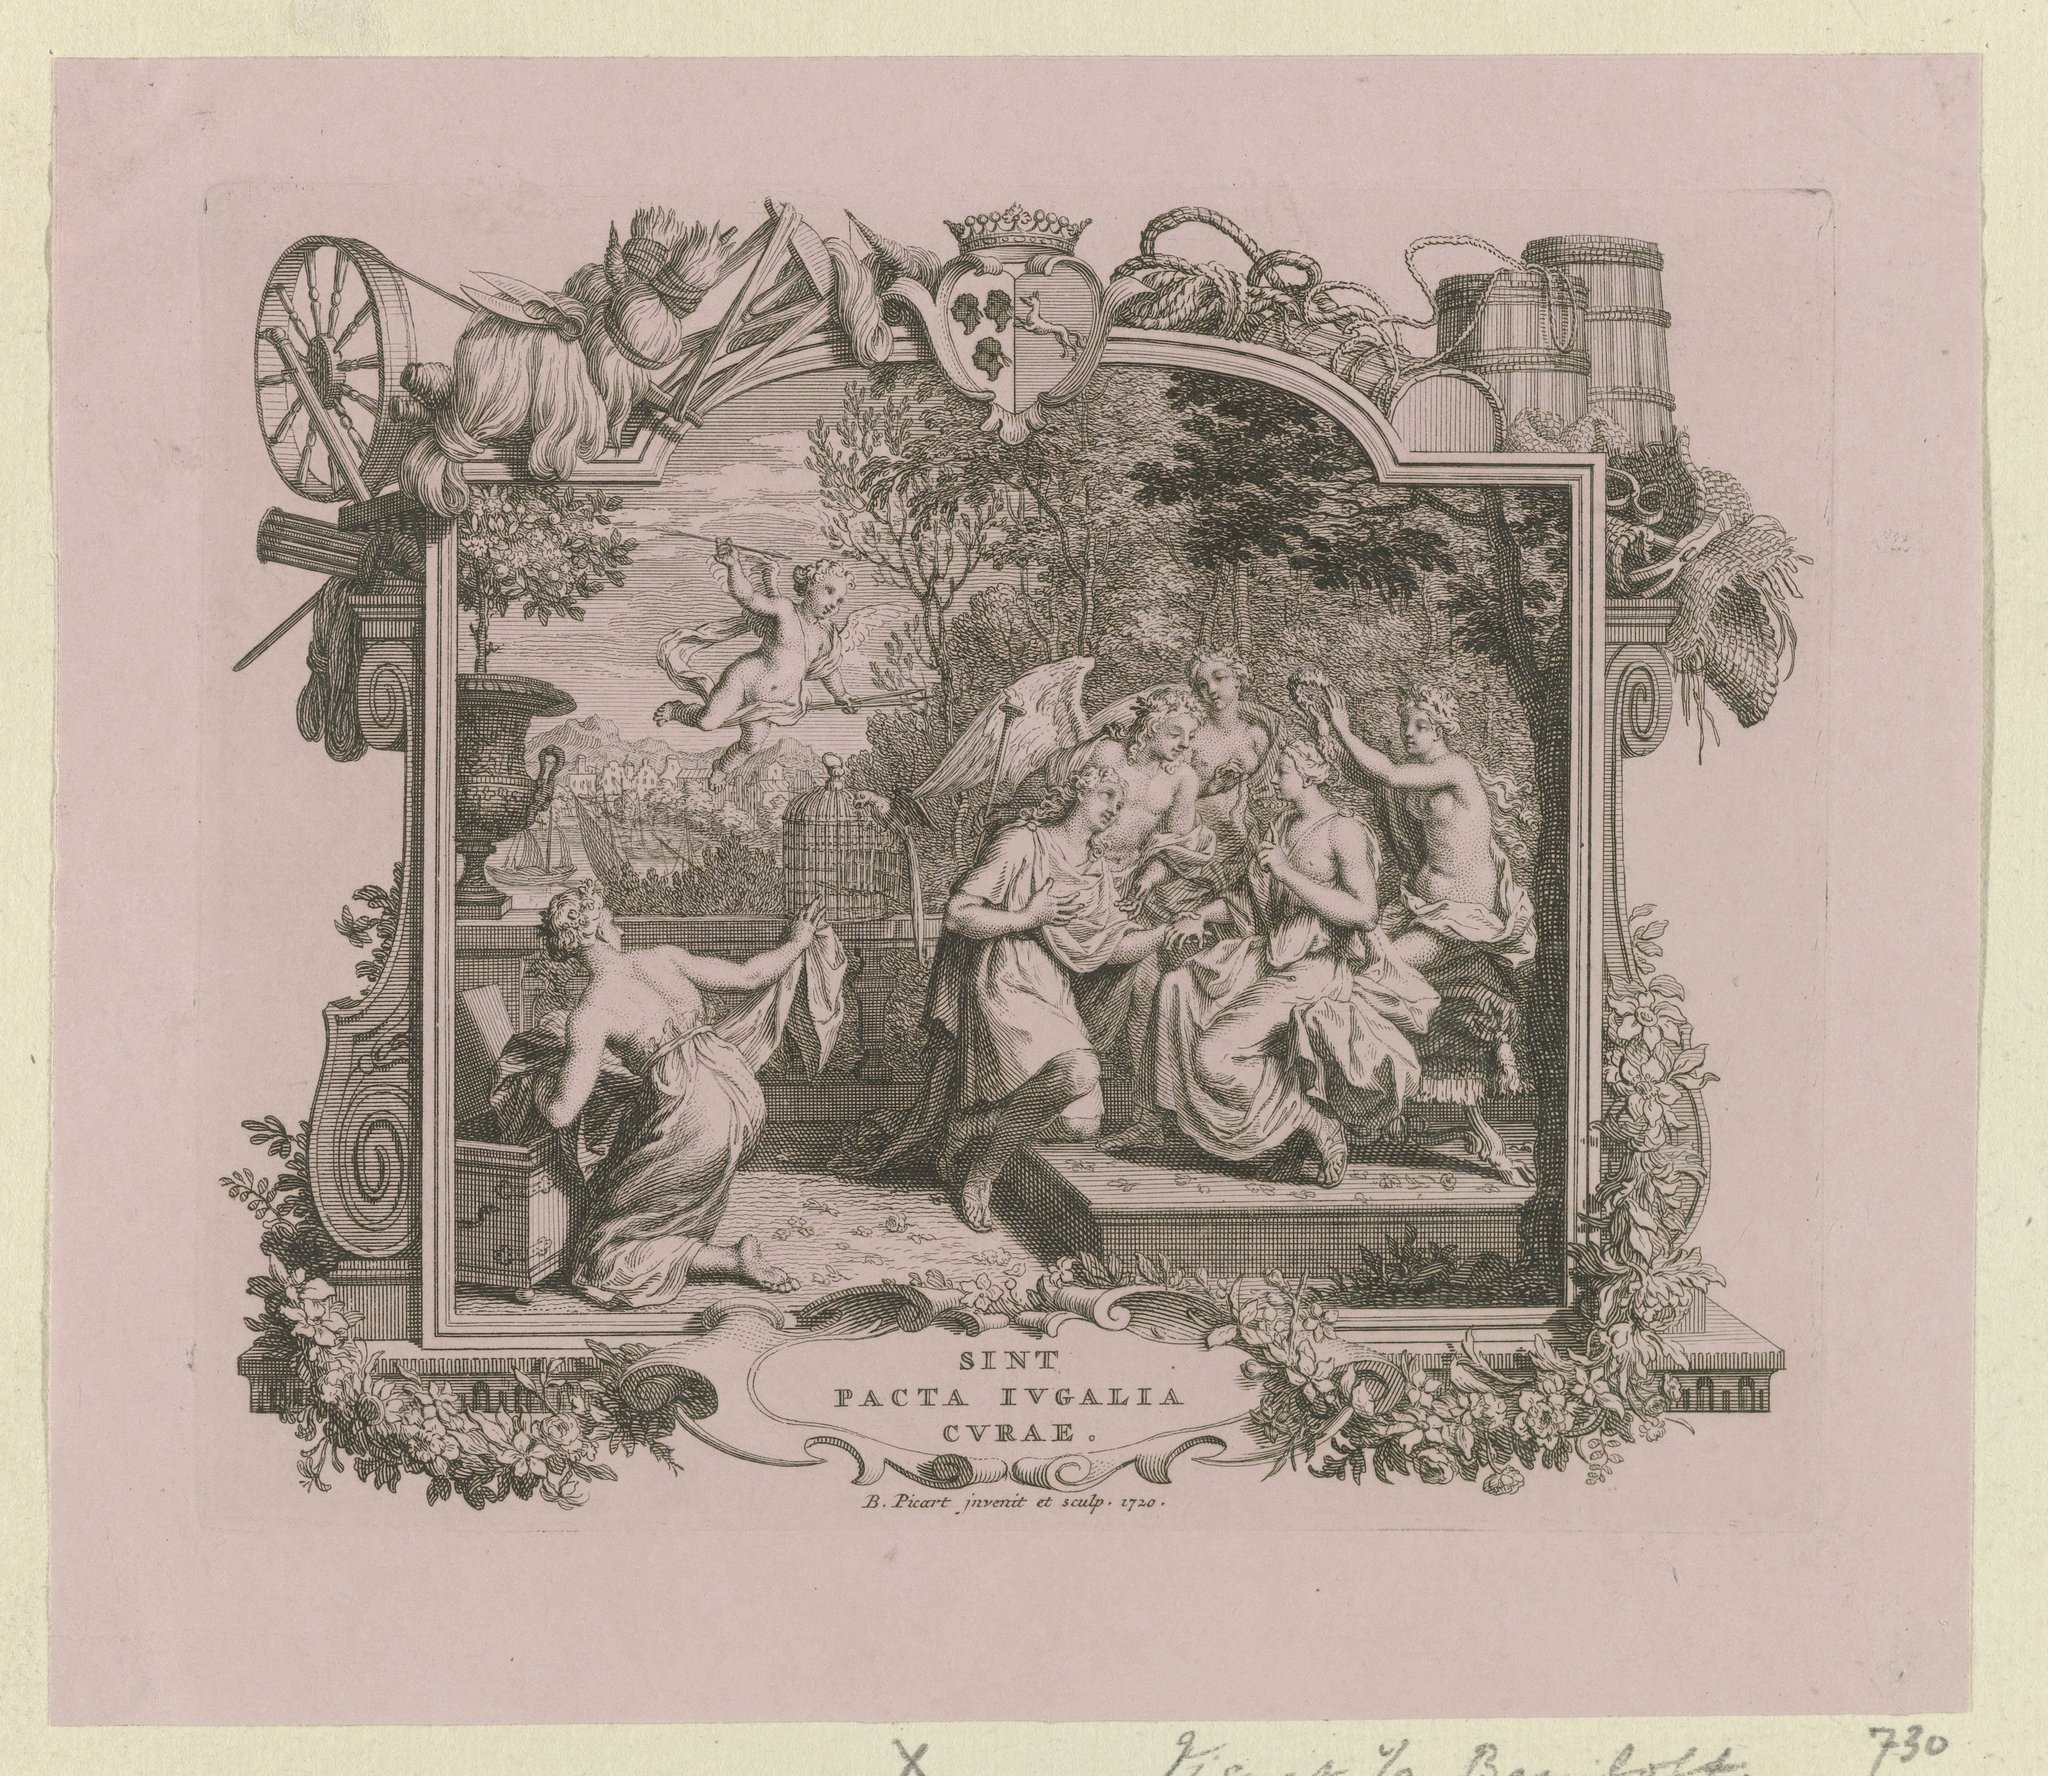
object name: marriage print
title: Allegorische voorstelling ter gelegenheid van het huwelijk van Willem Philips Kops en Johanna de Vos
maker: bernard picart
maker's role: draughtsman, print maker, publisher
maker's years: 1673-1733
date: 1720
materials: paper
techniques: engraving, etching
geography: amsterdam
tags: (story of) hymen(aeus), graces (charites), generally three in number; 'gratie' (ripa), marriage, married couple, 'matrimonium', (story of) cupid, amor (eros)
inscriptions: date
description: Allegorische voorstelling ter gelegenheid van het huwelijk van Willem Philips Kops en Johanna de Vos te Haarlem op 22 september 1720. De echtgenoot knielt gepassioneerd voor zijn vrouw. De huwelijksgod Hymen probeert hem tot rust te brengen. De drie gratieën kleden de bruid aan. Op de achtergrond de stad Haarlem. Bovenin de omlijsting handelswaar, horend bij de onderneming van het paar. Onder de voorstelling het devies: Sint Pacta Jugalia Curae. De prent maakt deel uit van een album.